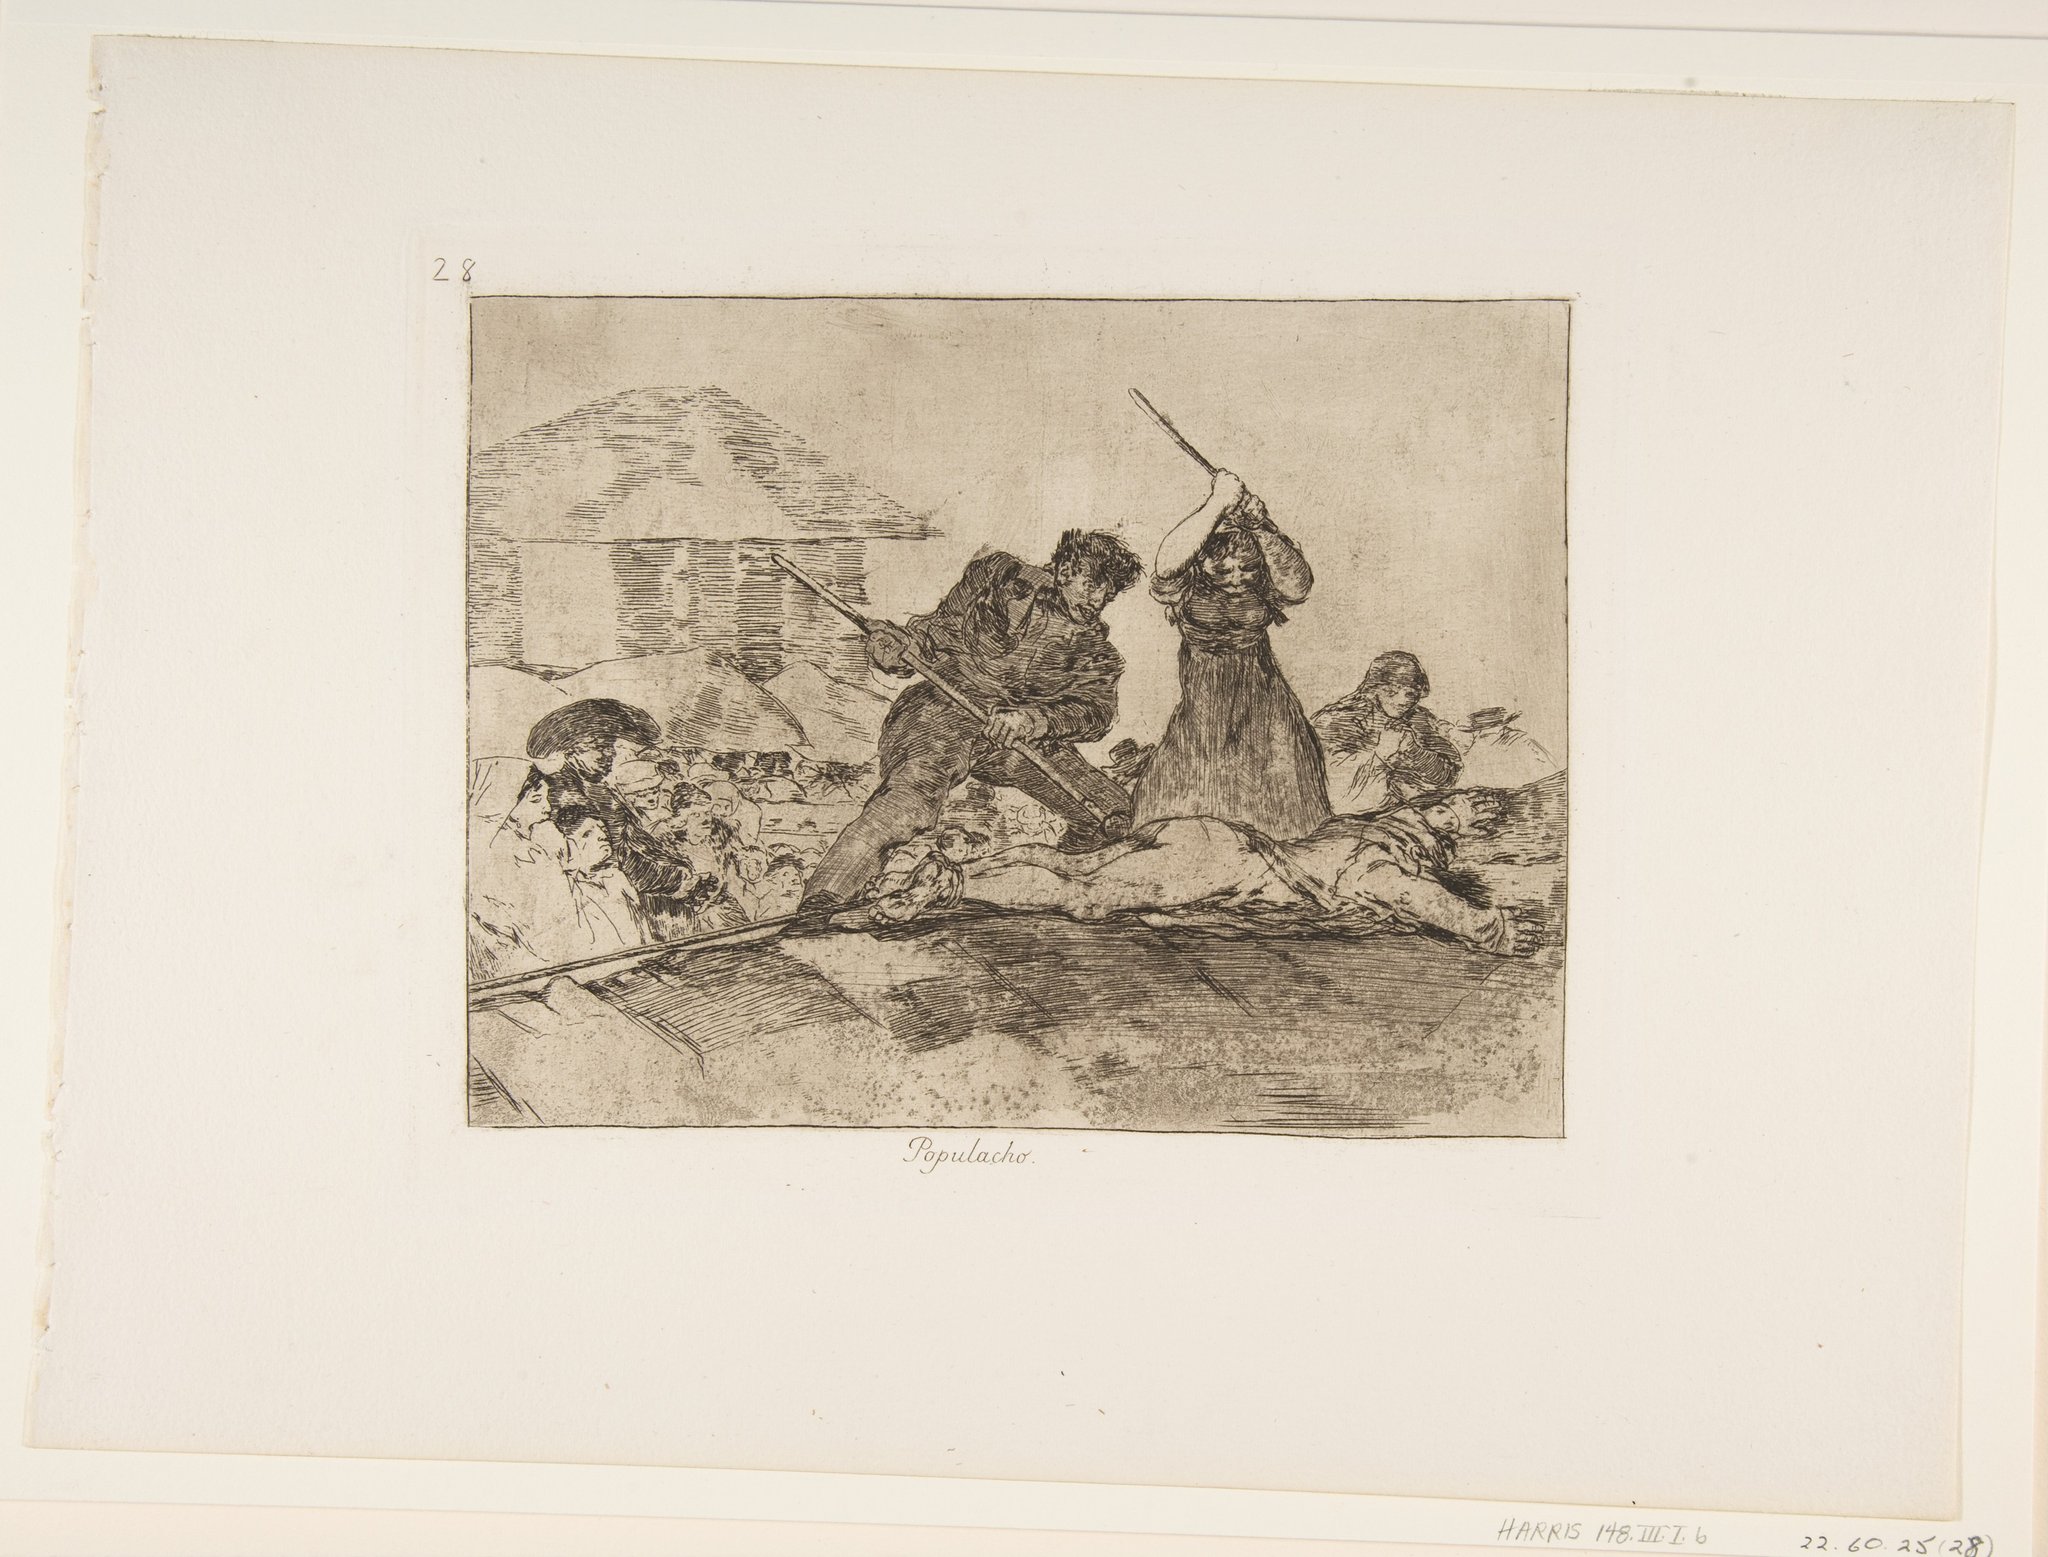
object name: print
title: Plate 28 from "The Disasters of War" (Los Desastres de la Guerra): 'Rabble' (Populacho)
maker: goya (francisco de goya y lucientes)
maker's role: artist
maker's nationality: spanish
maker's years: 1746-1828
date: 1810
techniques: engraving, drypoint, etching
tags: suffering,men,women